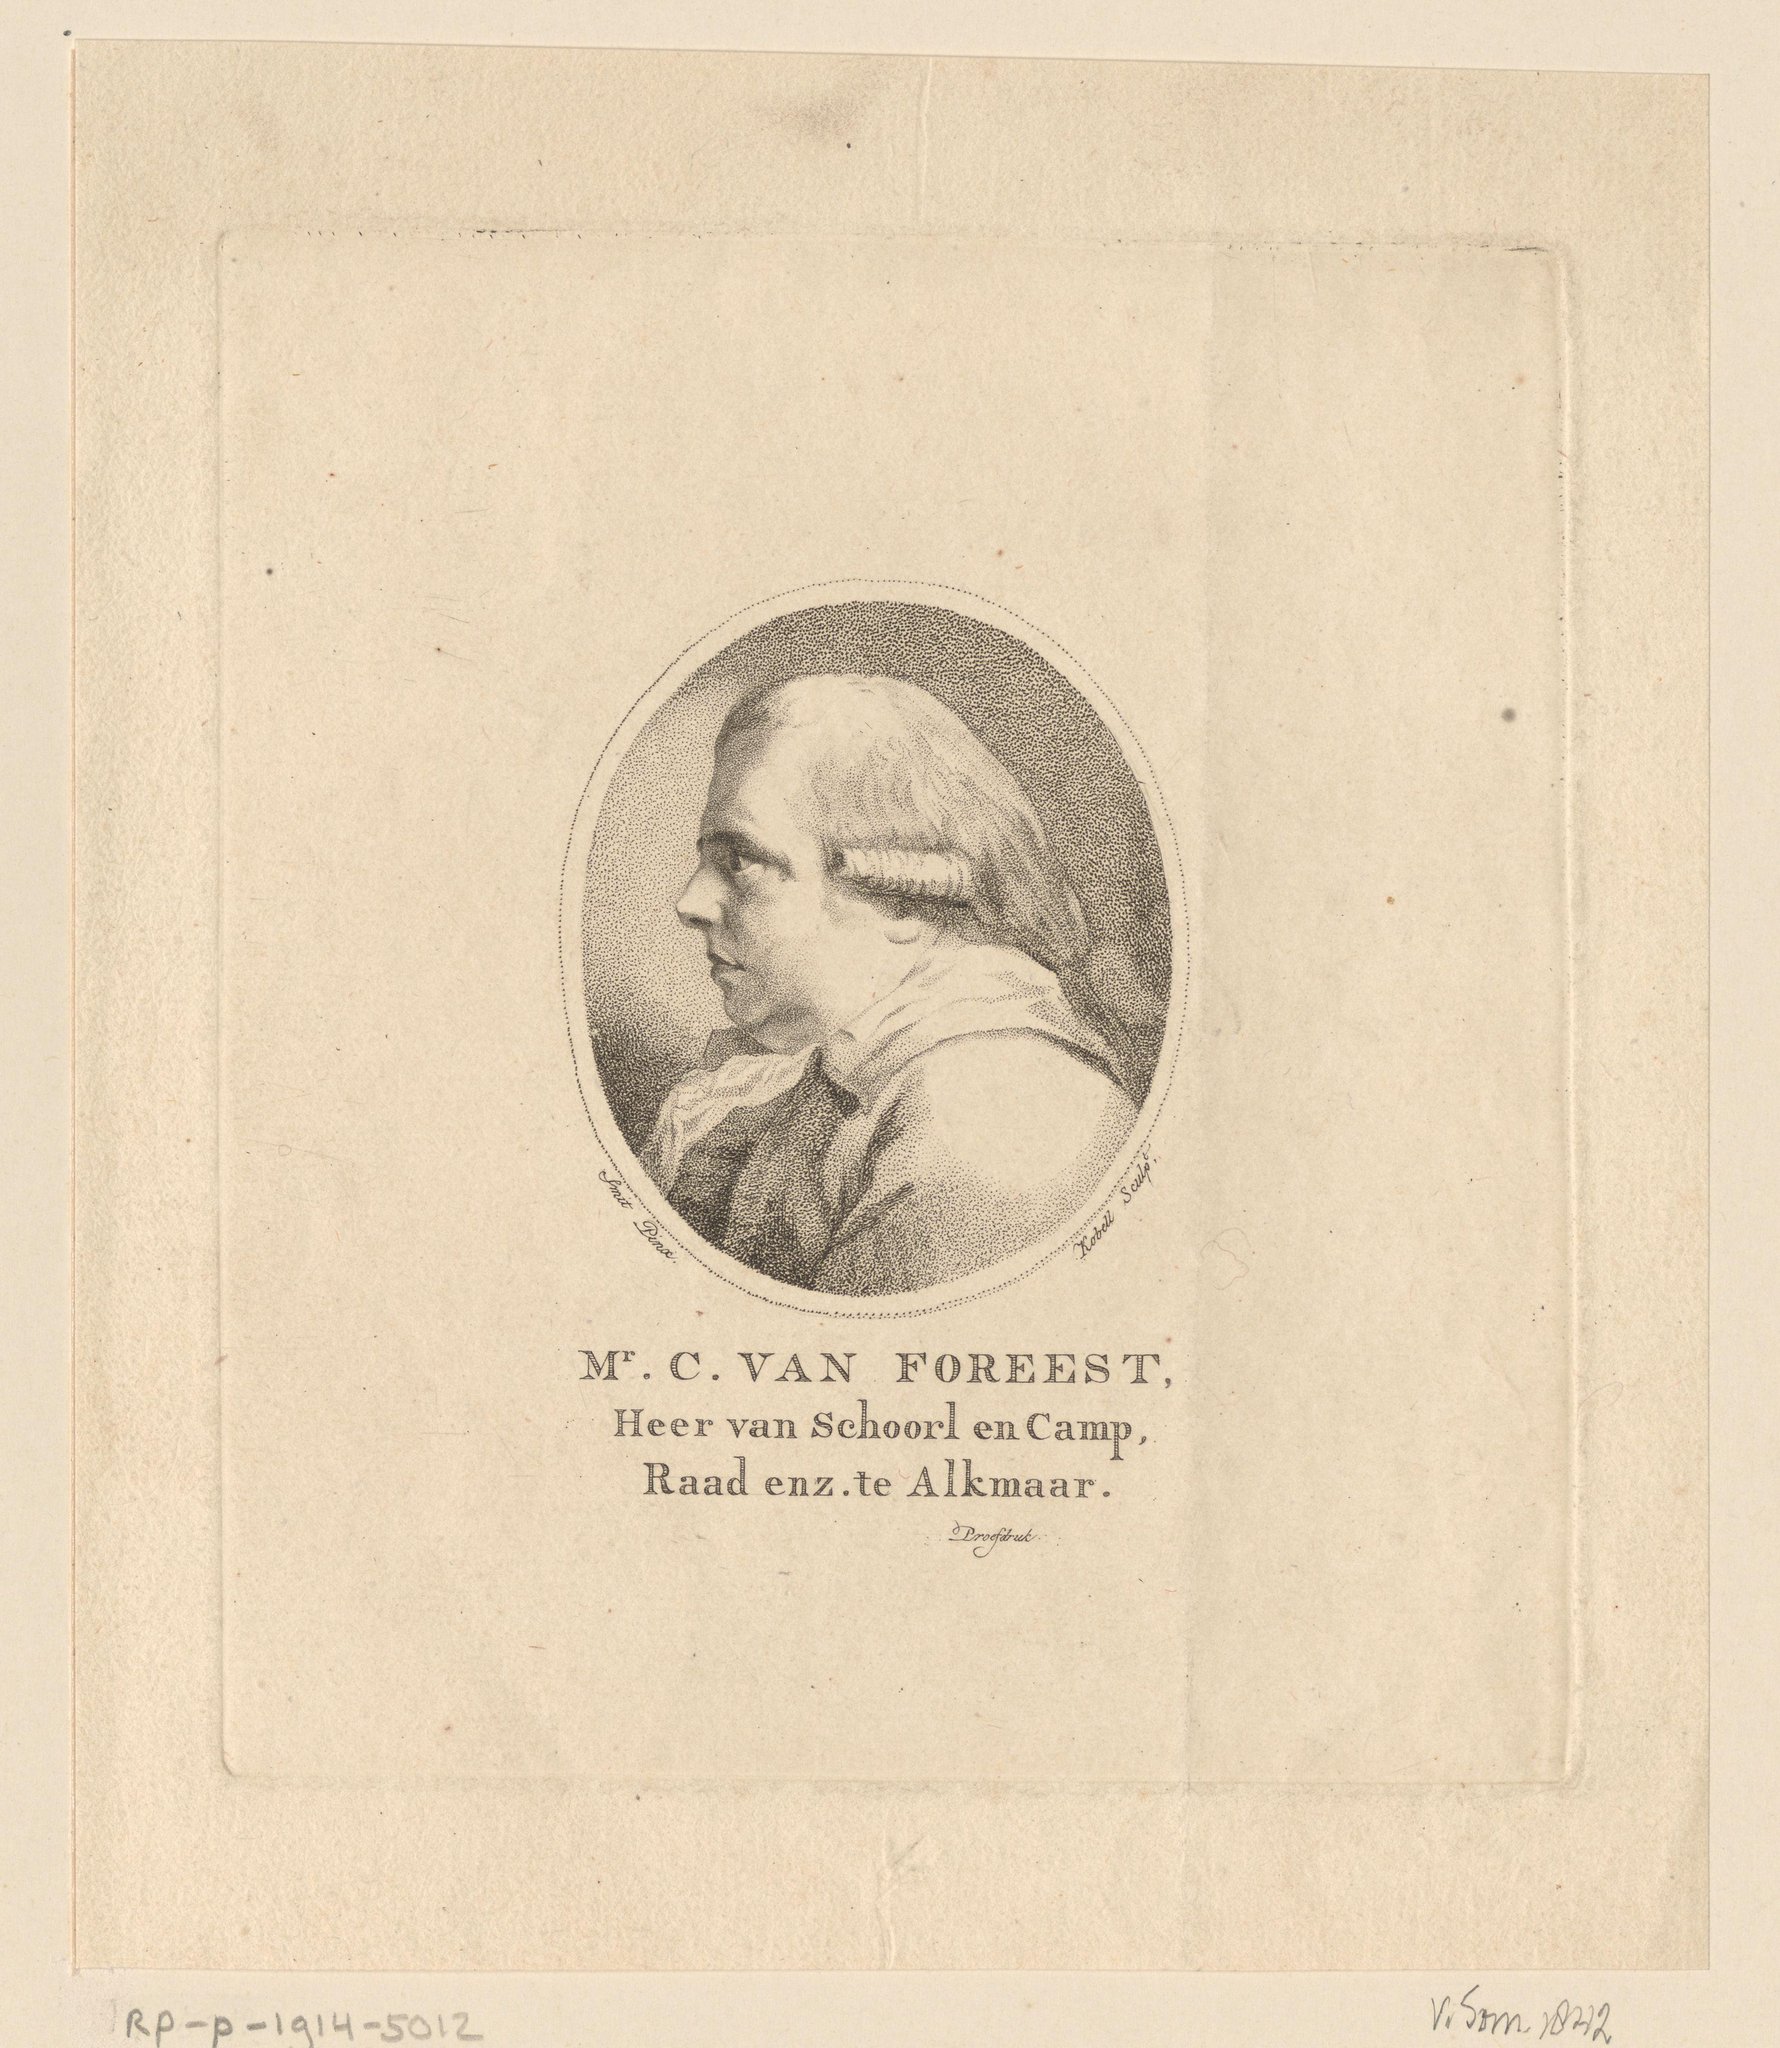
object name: print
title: Portret van Cornelis van Foreest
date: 1778-1833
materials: paper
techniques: etching, engraving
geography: rotterdam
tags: historical persons, wig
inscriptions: collector's mark: Lugt 2228